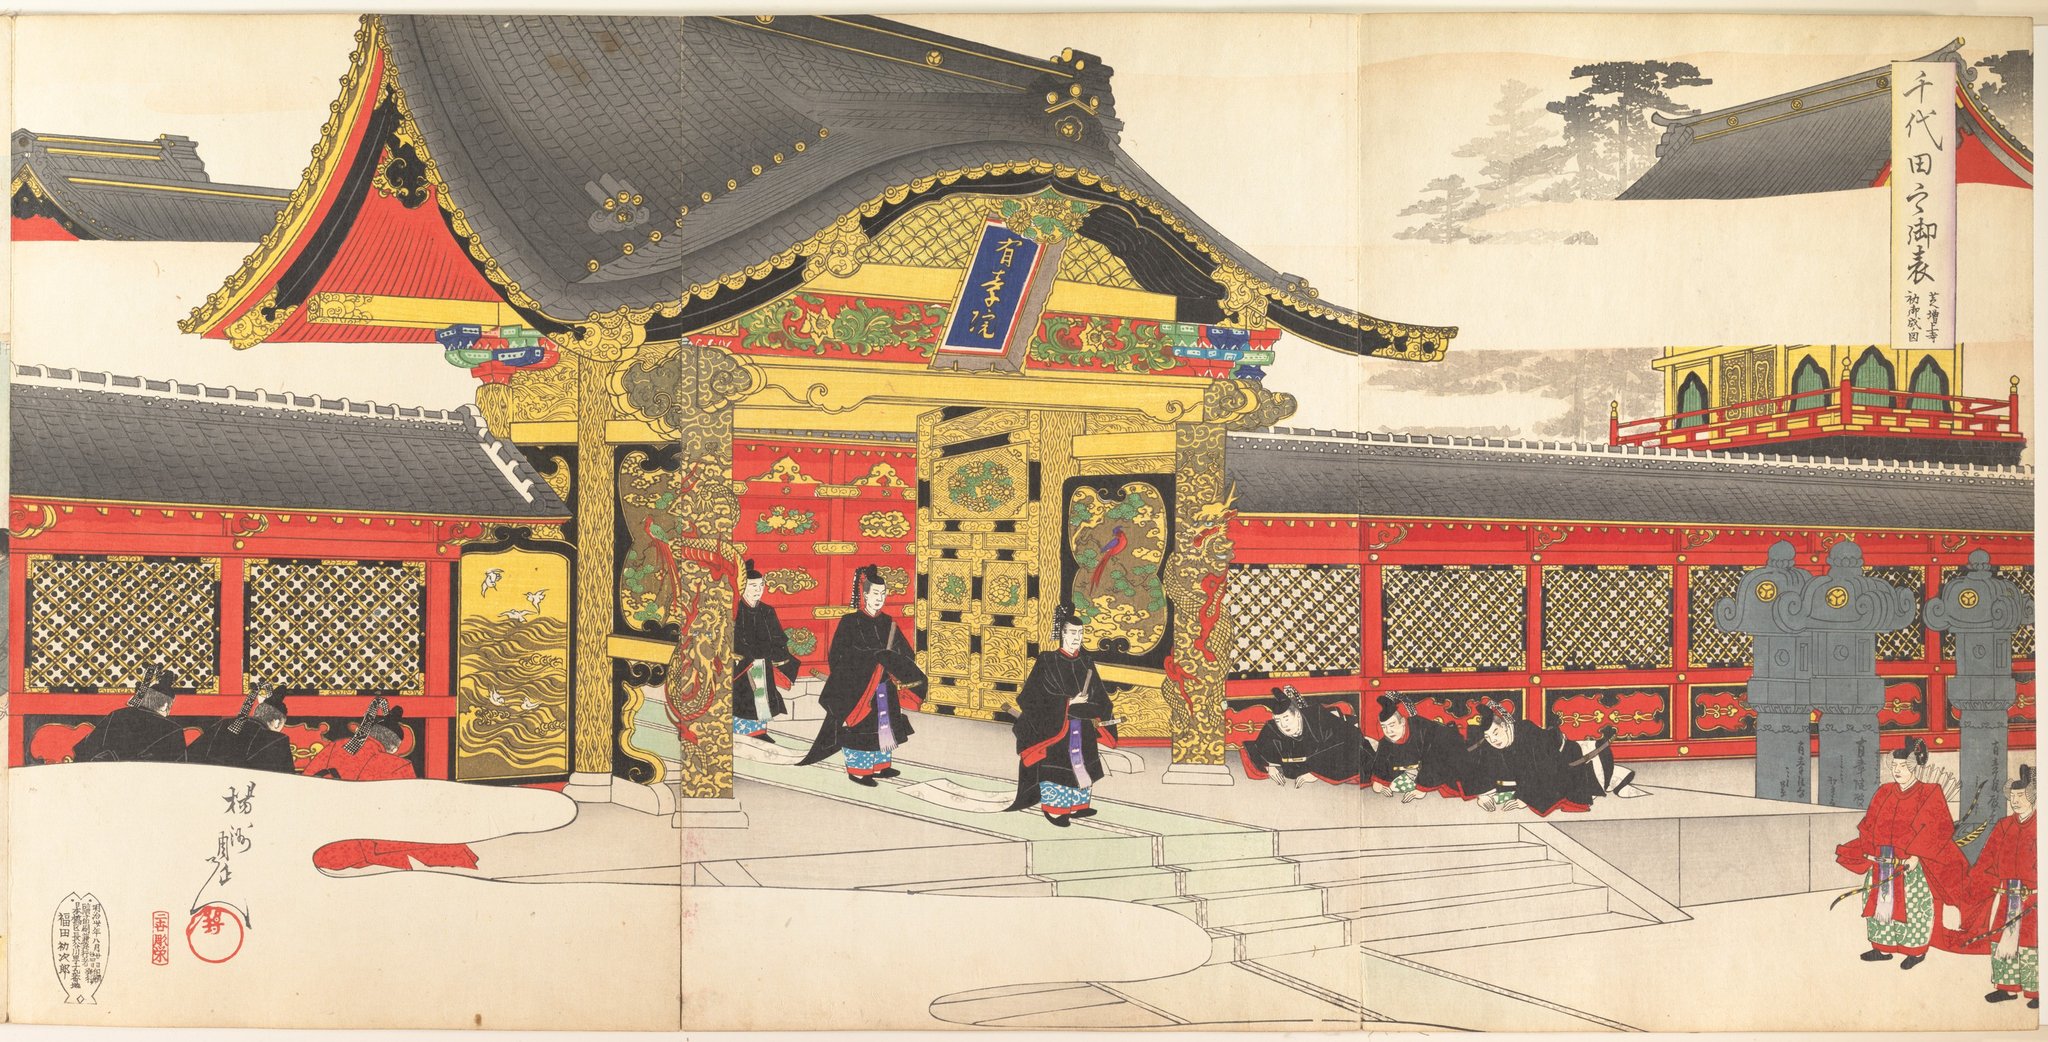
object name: print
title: Chiyoda Castle (Album of Men)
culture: japanese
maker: yōshū (hashimoto) chikanobu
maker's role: artist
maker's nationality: japanese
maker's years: 1838-1912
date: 1897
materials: ink, paper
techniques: woodblock print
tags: castles,gates,men